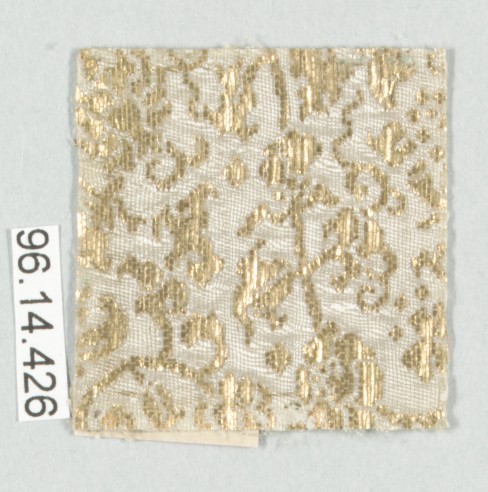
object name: piece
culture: japanese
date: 1701-1900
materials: silk